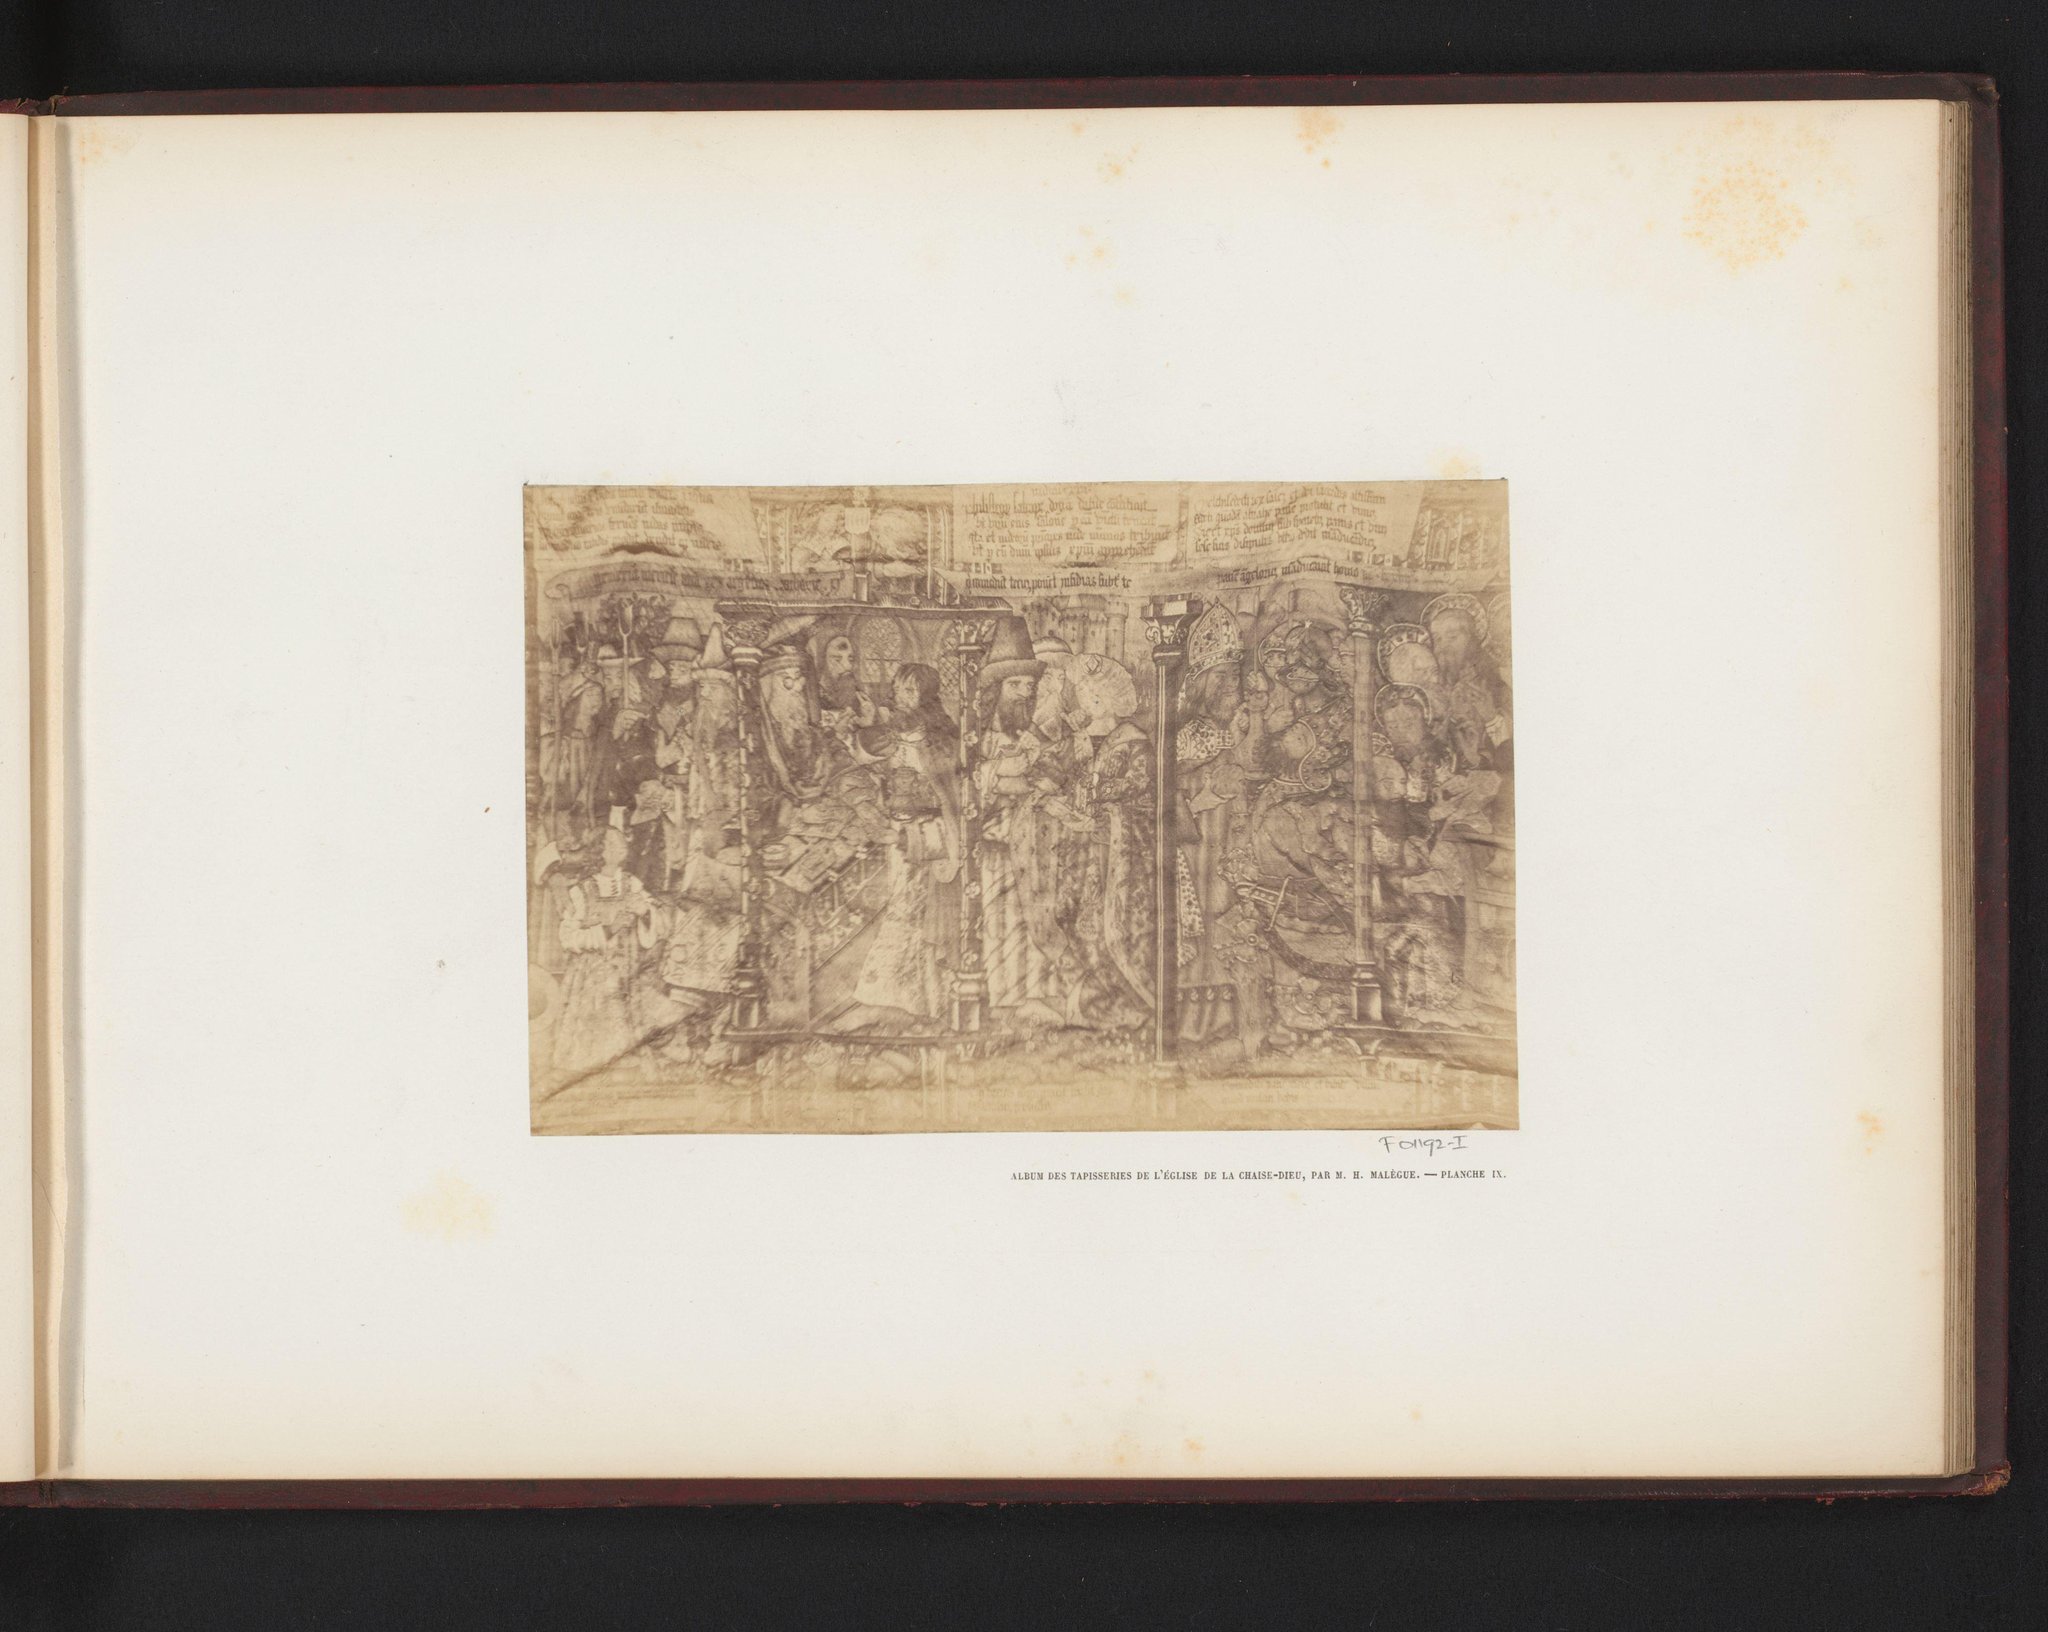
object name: page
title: Tapijt met het verraad van Judas en prefiguraties in een kerk te La Chaise-Dieu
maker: hippolyte malègue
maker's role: archeoloog, fotograaf, schrijver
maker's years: 1825-1901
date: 1868-1873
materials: photographic support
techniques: albumen print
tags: tapestry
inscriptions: inscription: ‘album des tapisseries de l'église de la Chaise-Dieu, par M. H. Malegue - Planche IX’